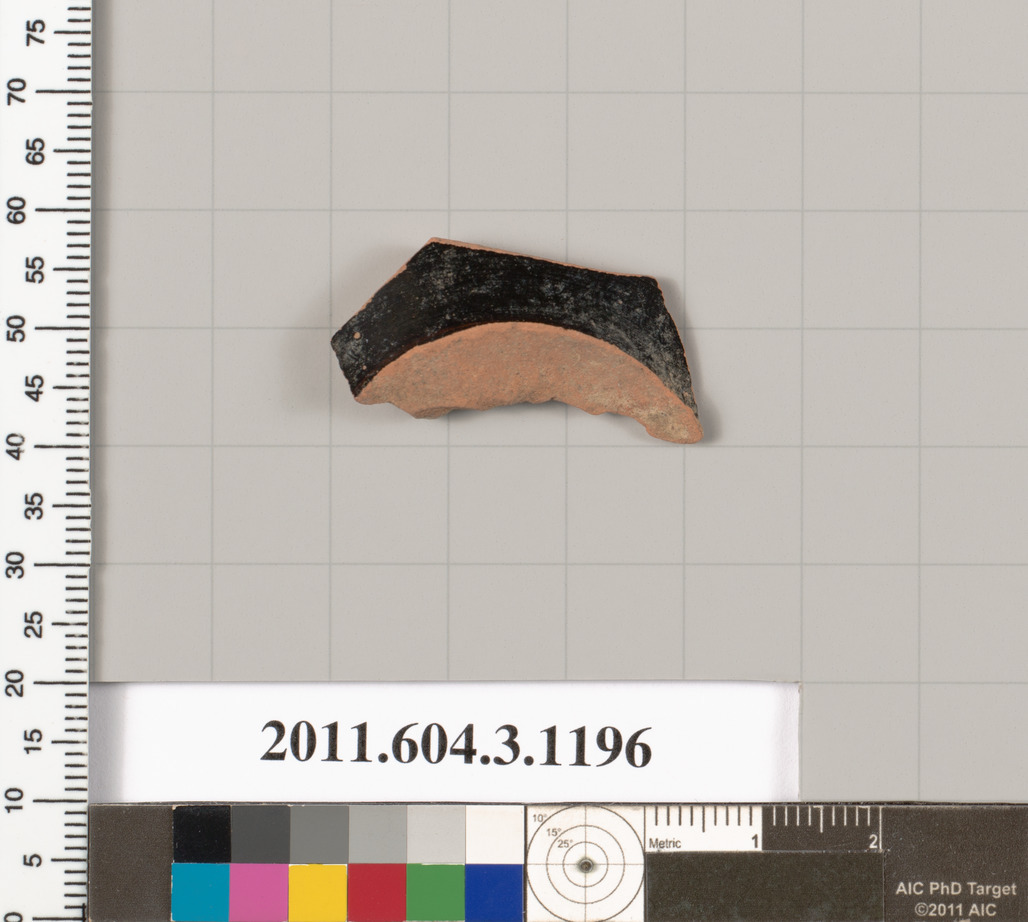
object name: mastoid fragment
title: Terracotta fragment of a mastoid (drinking cup with narrow base)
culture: greek, attic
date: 534-468 BCE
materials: terracotta